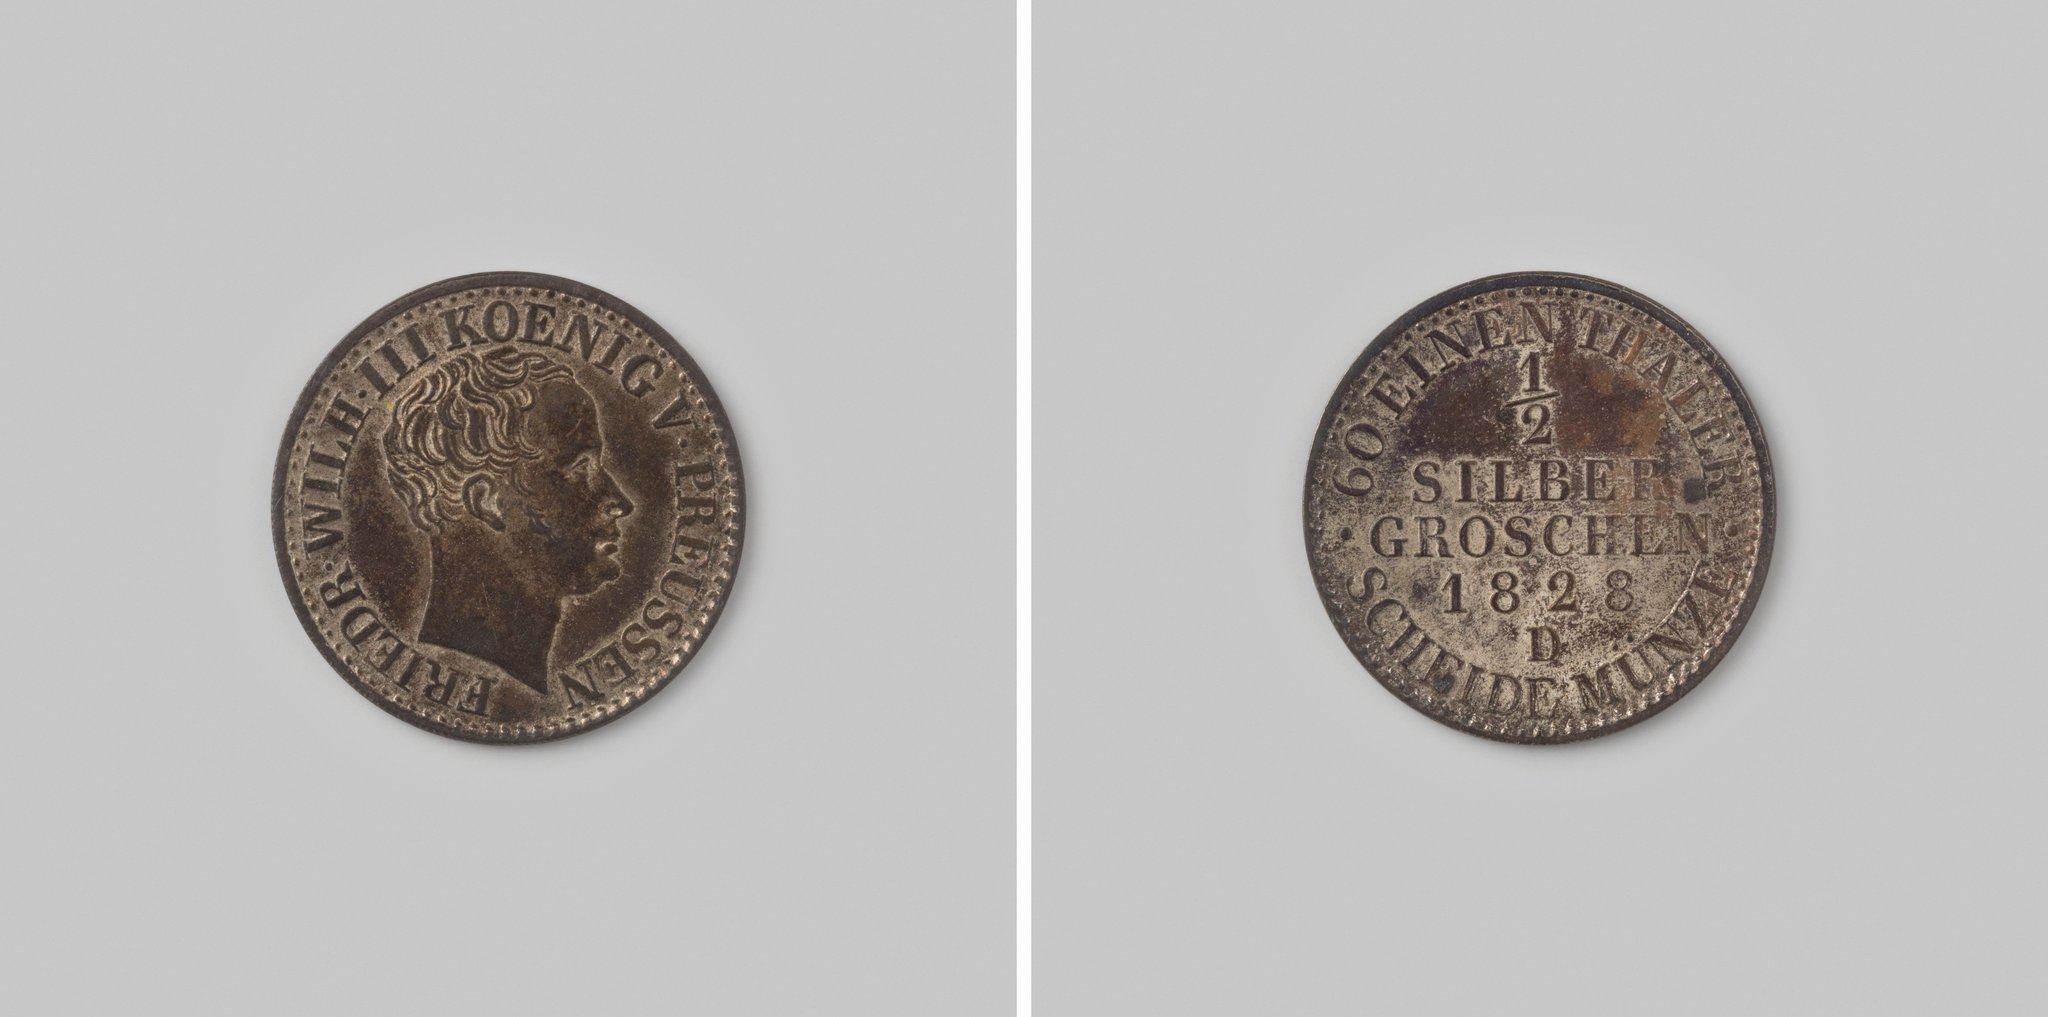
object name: coin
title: ½ Silbergroschen uit Pruisen van Friedrich Wilhelm III, 1828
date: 1828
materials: silver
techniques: striking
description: Zilveren munt. Voorzijde: hoofd van de koning naar rechts. Keerzijde: waarde-aanduiding in drie regels, waaronder jaartal. Daaronder letter D. Gladde rand.